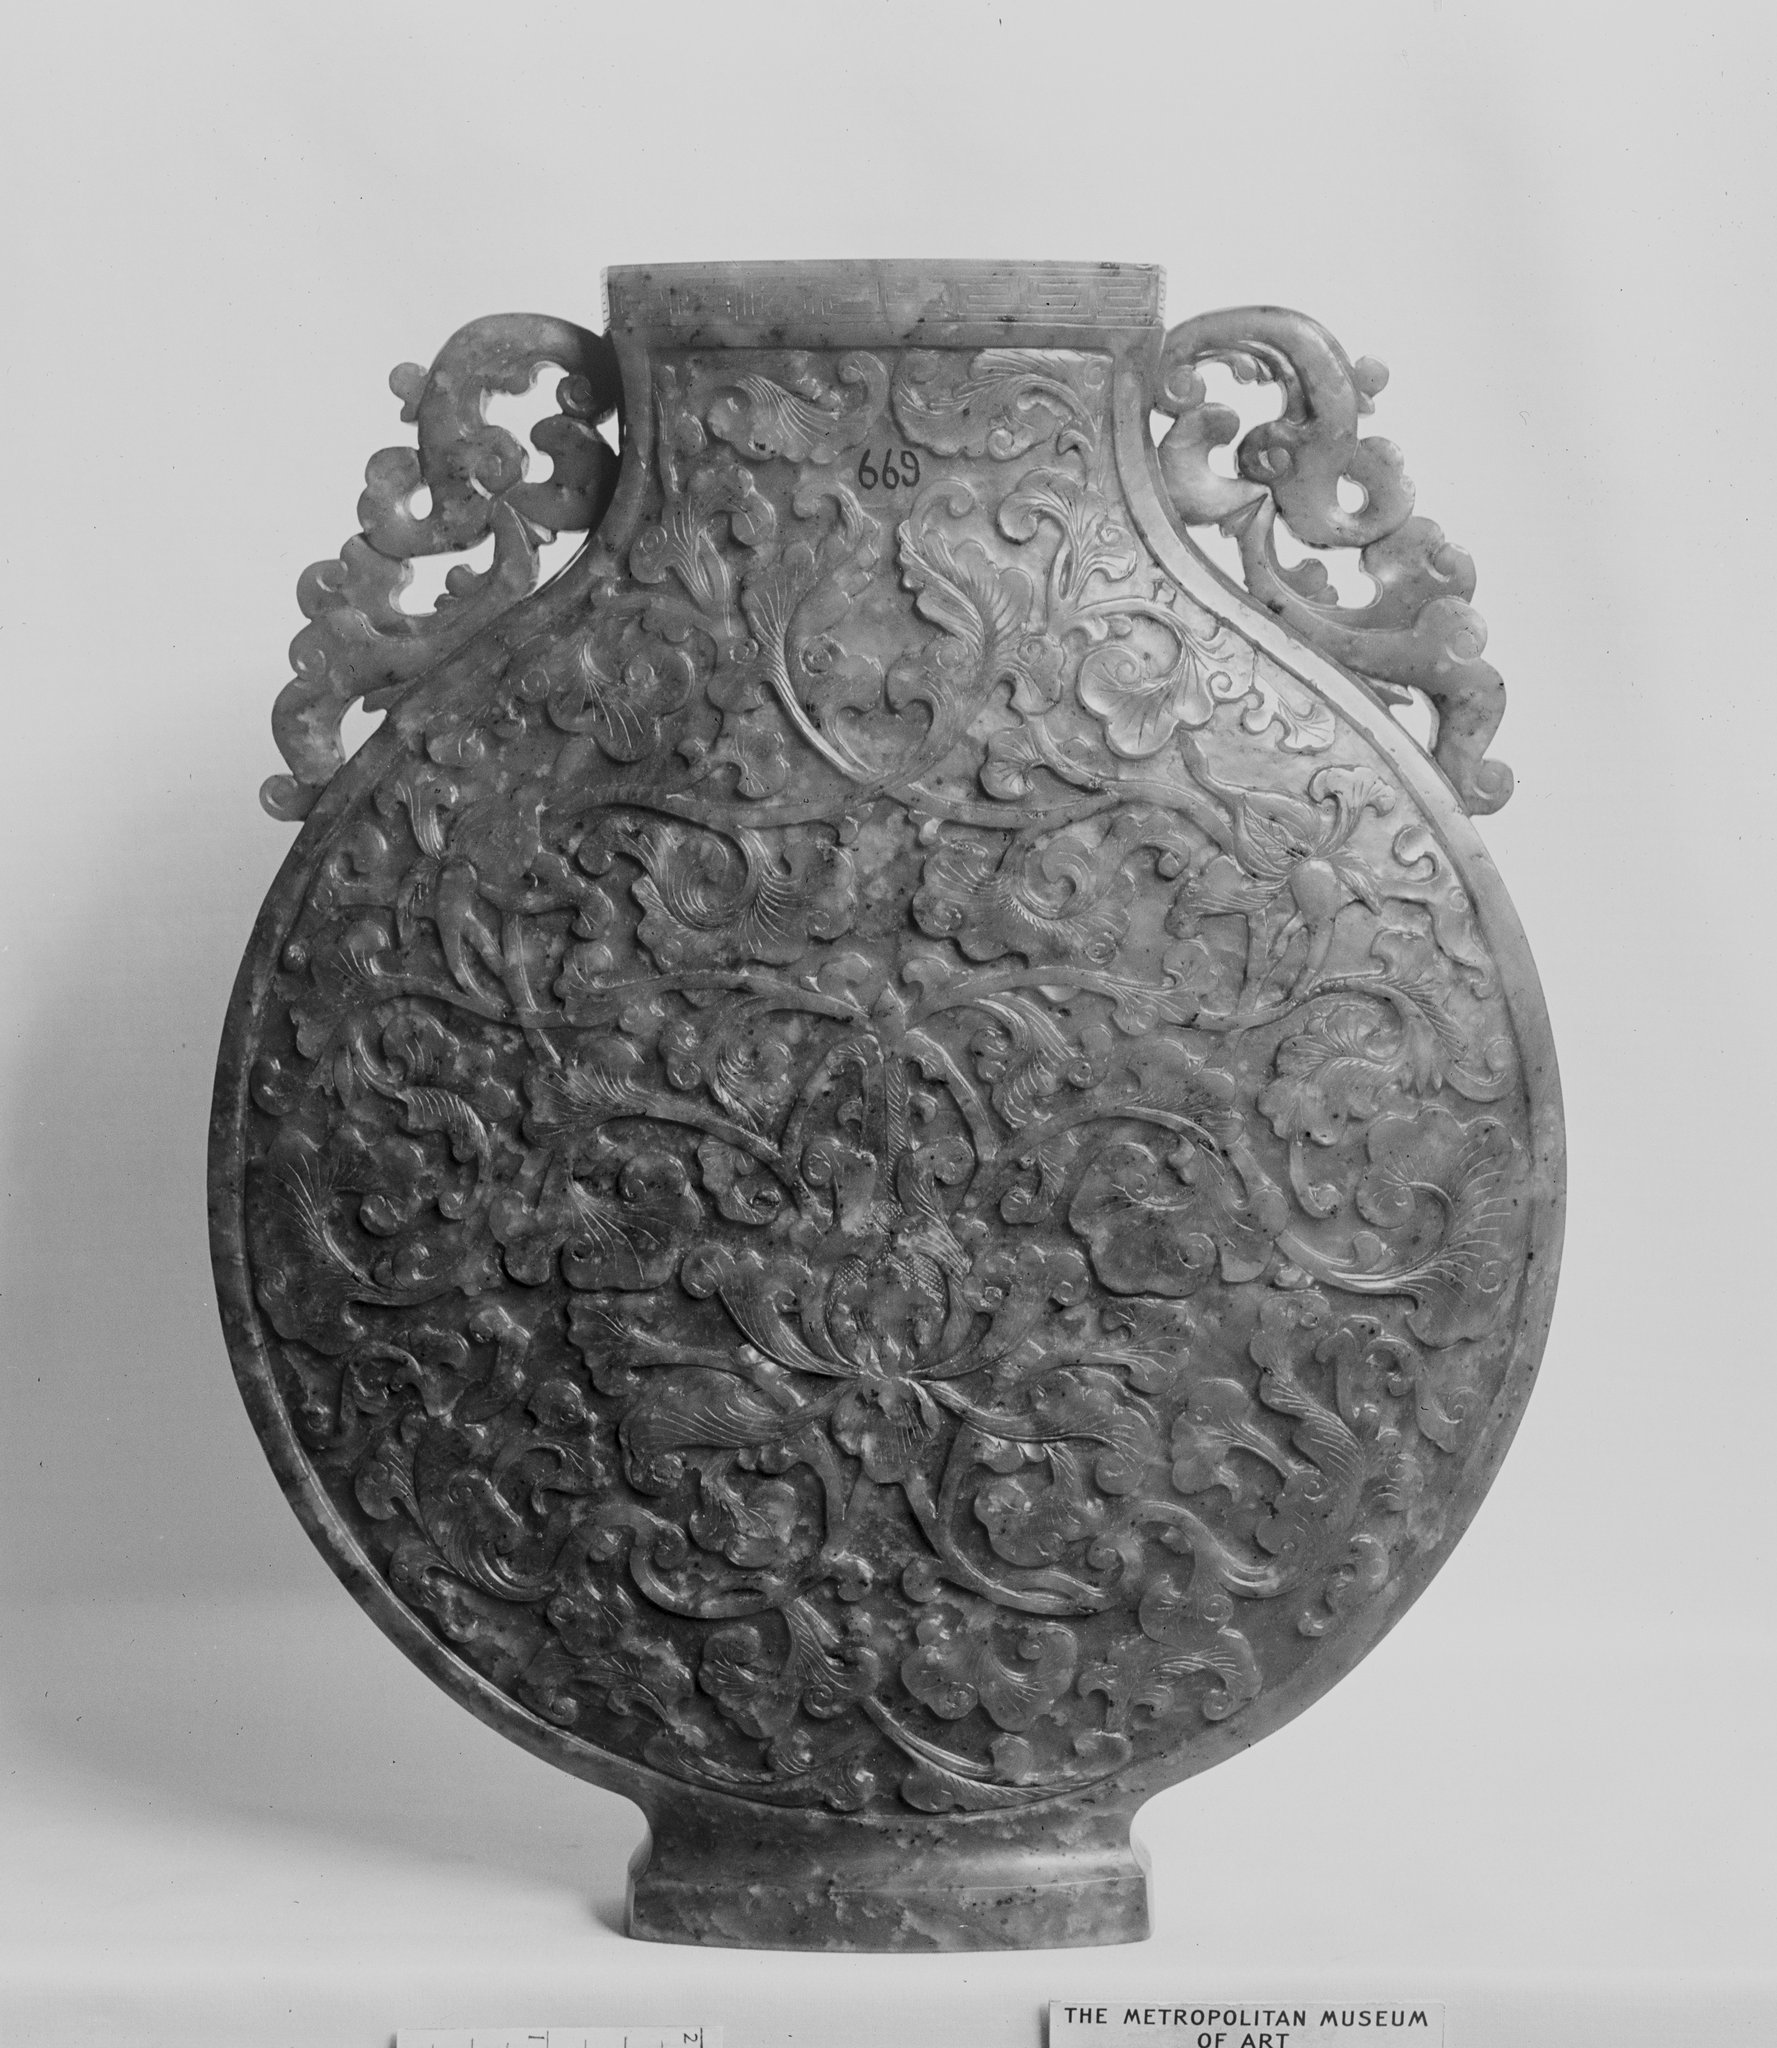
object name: pilgrim's bottle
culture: chinese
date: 1736-1795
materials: jade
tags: leaves